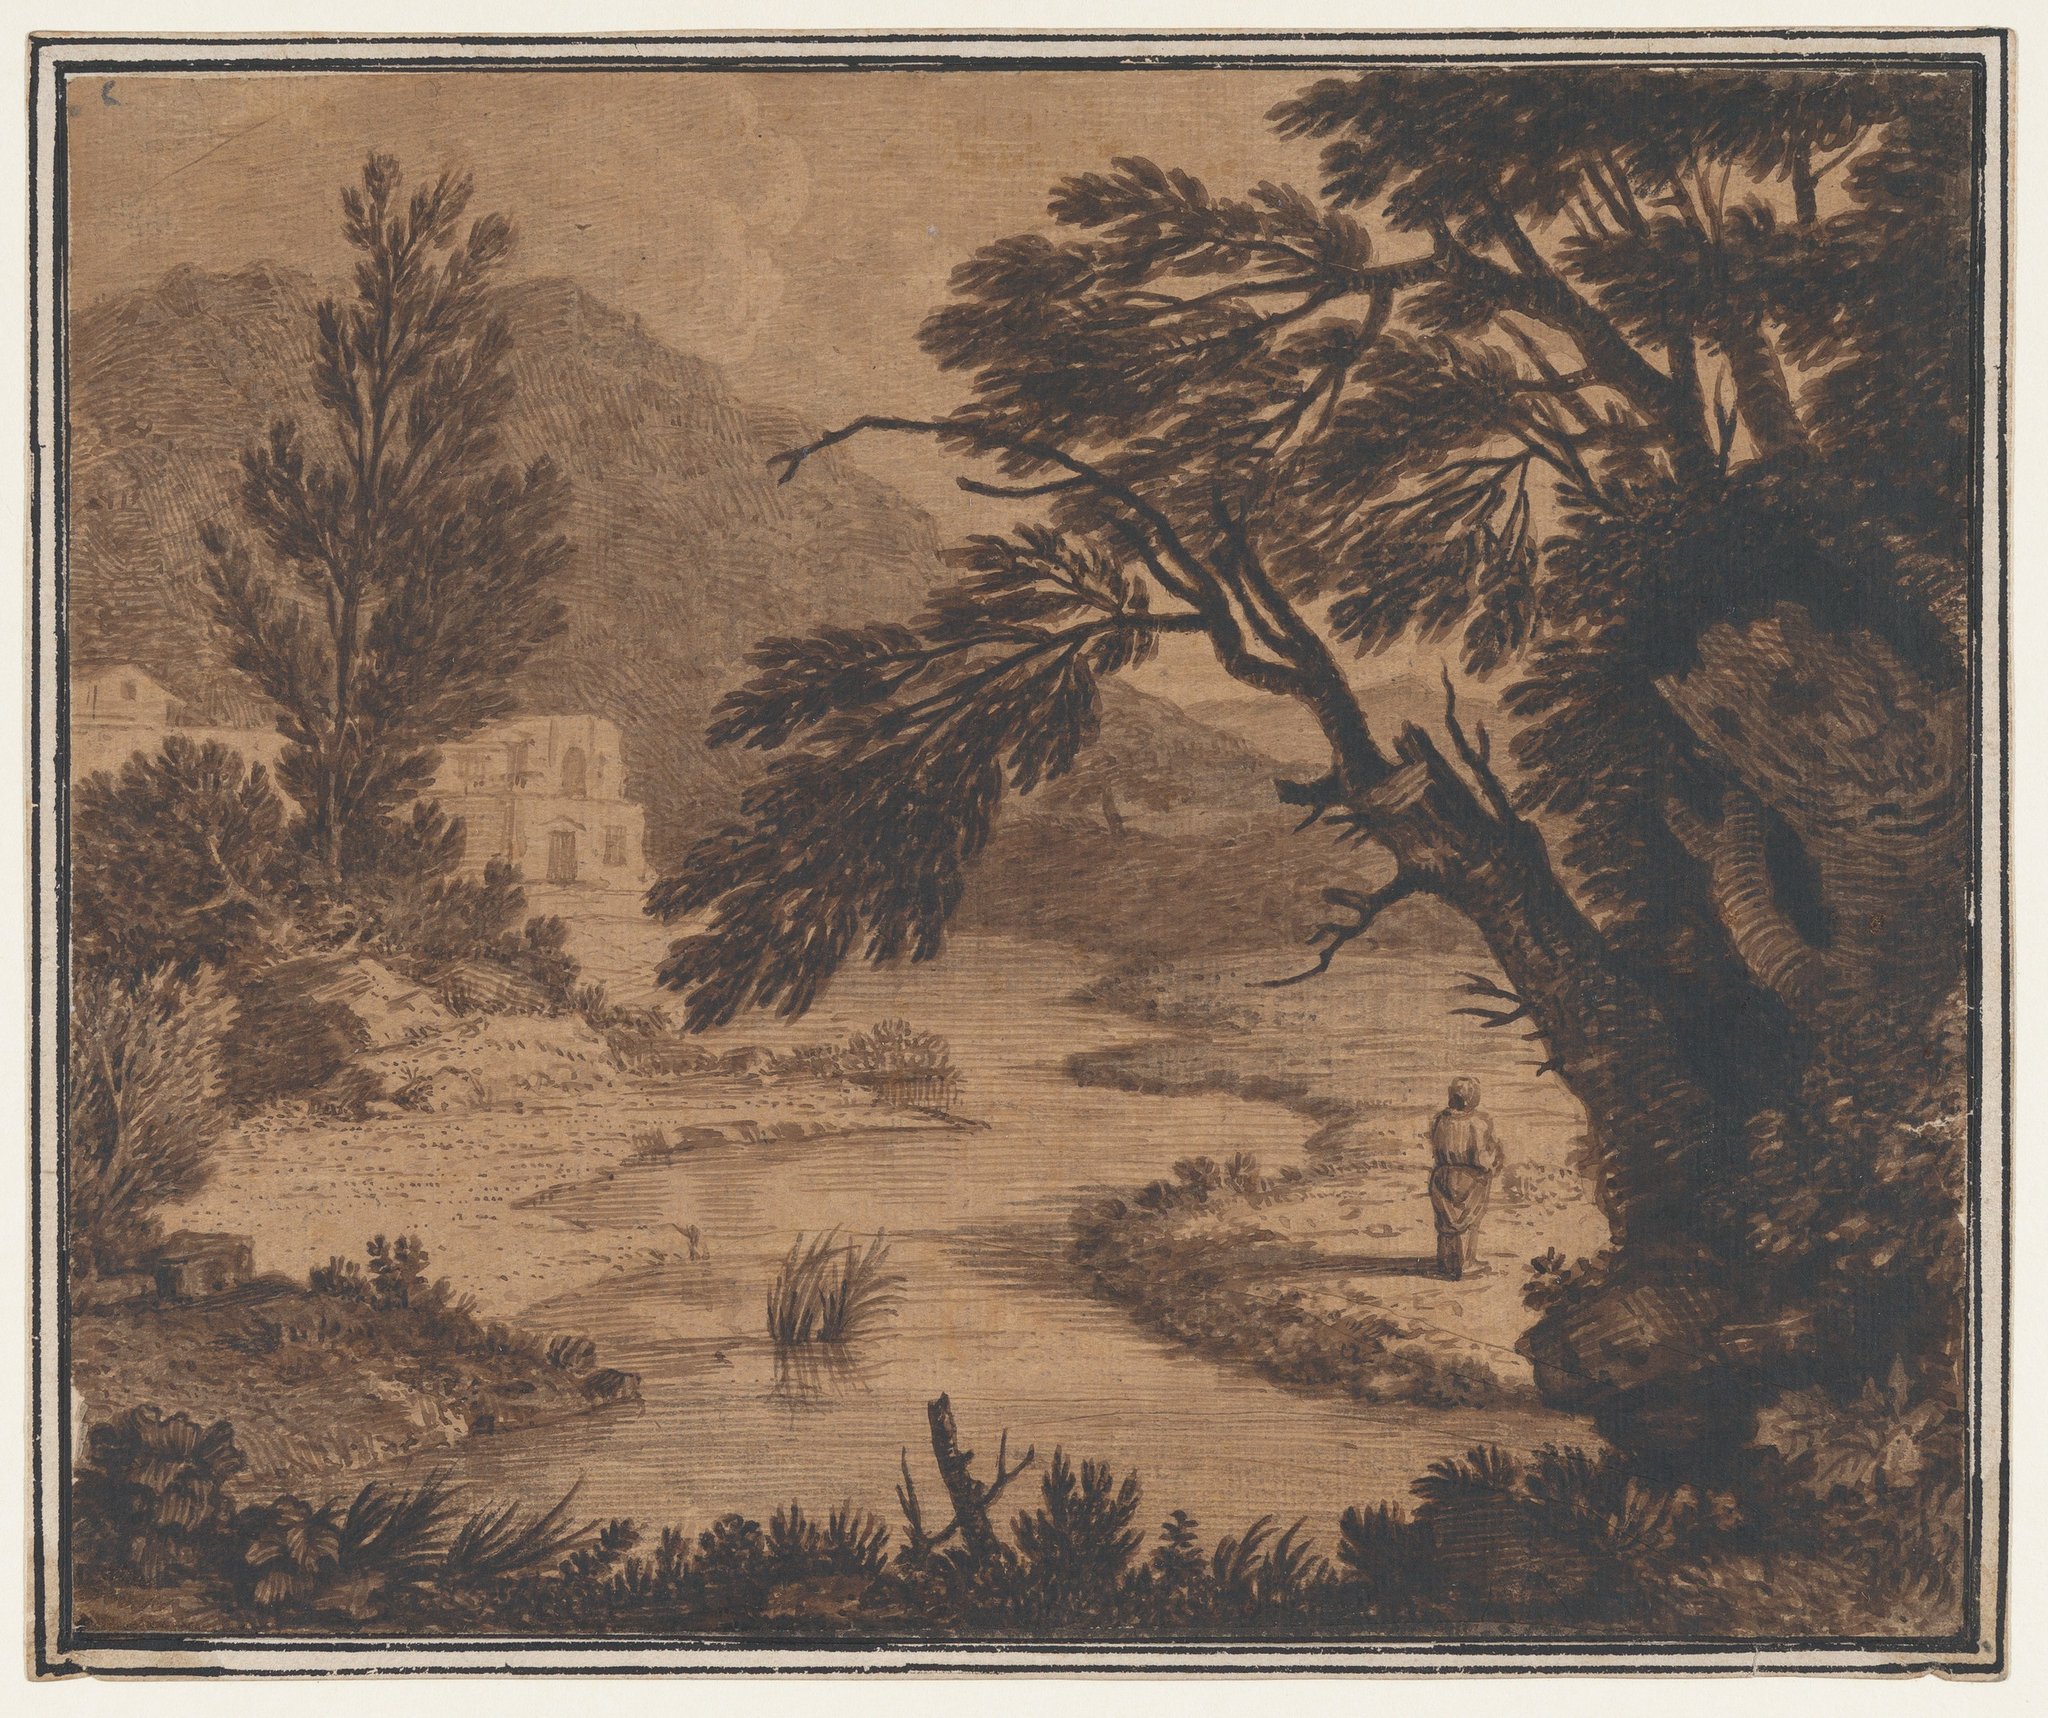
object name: drawing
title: Figure in a classical landscape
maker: alexander cozens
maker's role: artist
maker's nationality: british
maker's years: 1717-1786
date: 1755-1765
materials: ink, paper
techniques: brush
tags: women,landscapes,trees